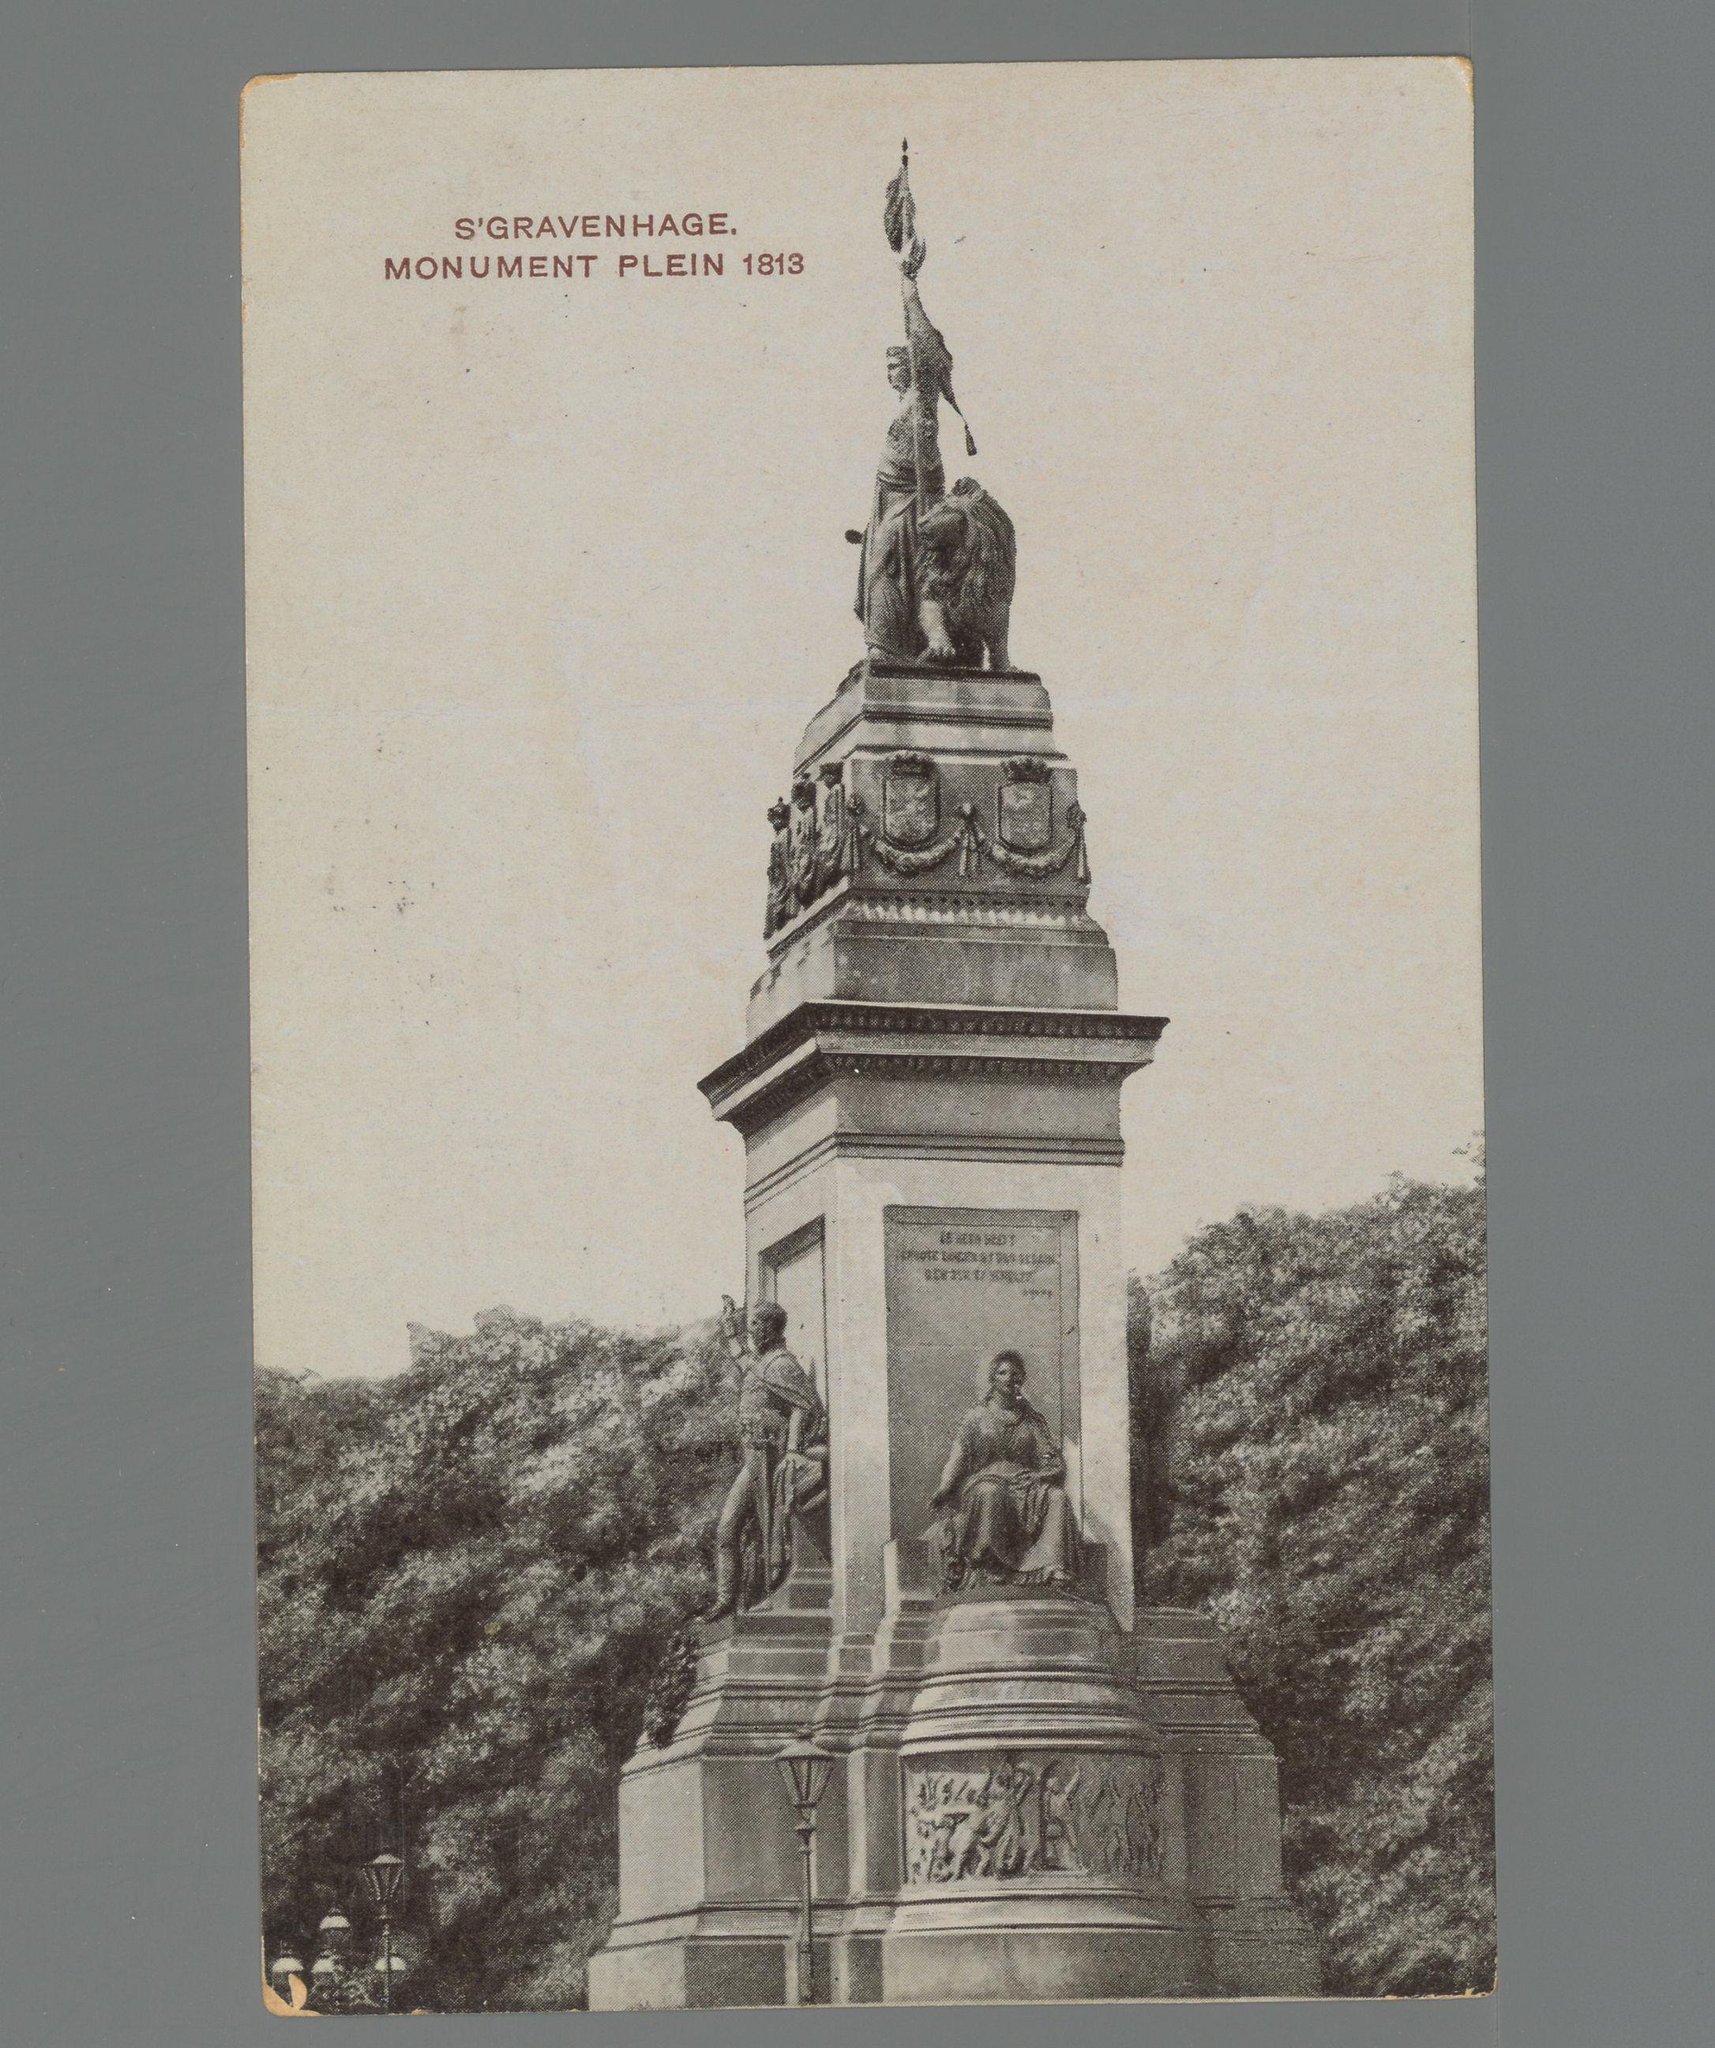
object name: photomechanical print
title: s'Gravenhage. Monument Plein 1813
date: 1906-1909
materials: cardboard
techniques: writing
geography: the hague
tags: monument, statue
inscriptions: postage stamp